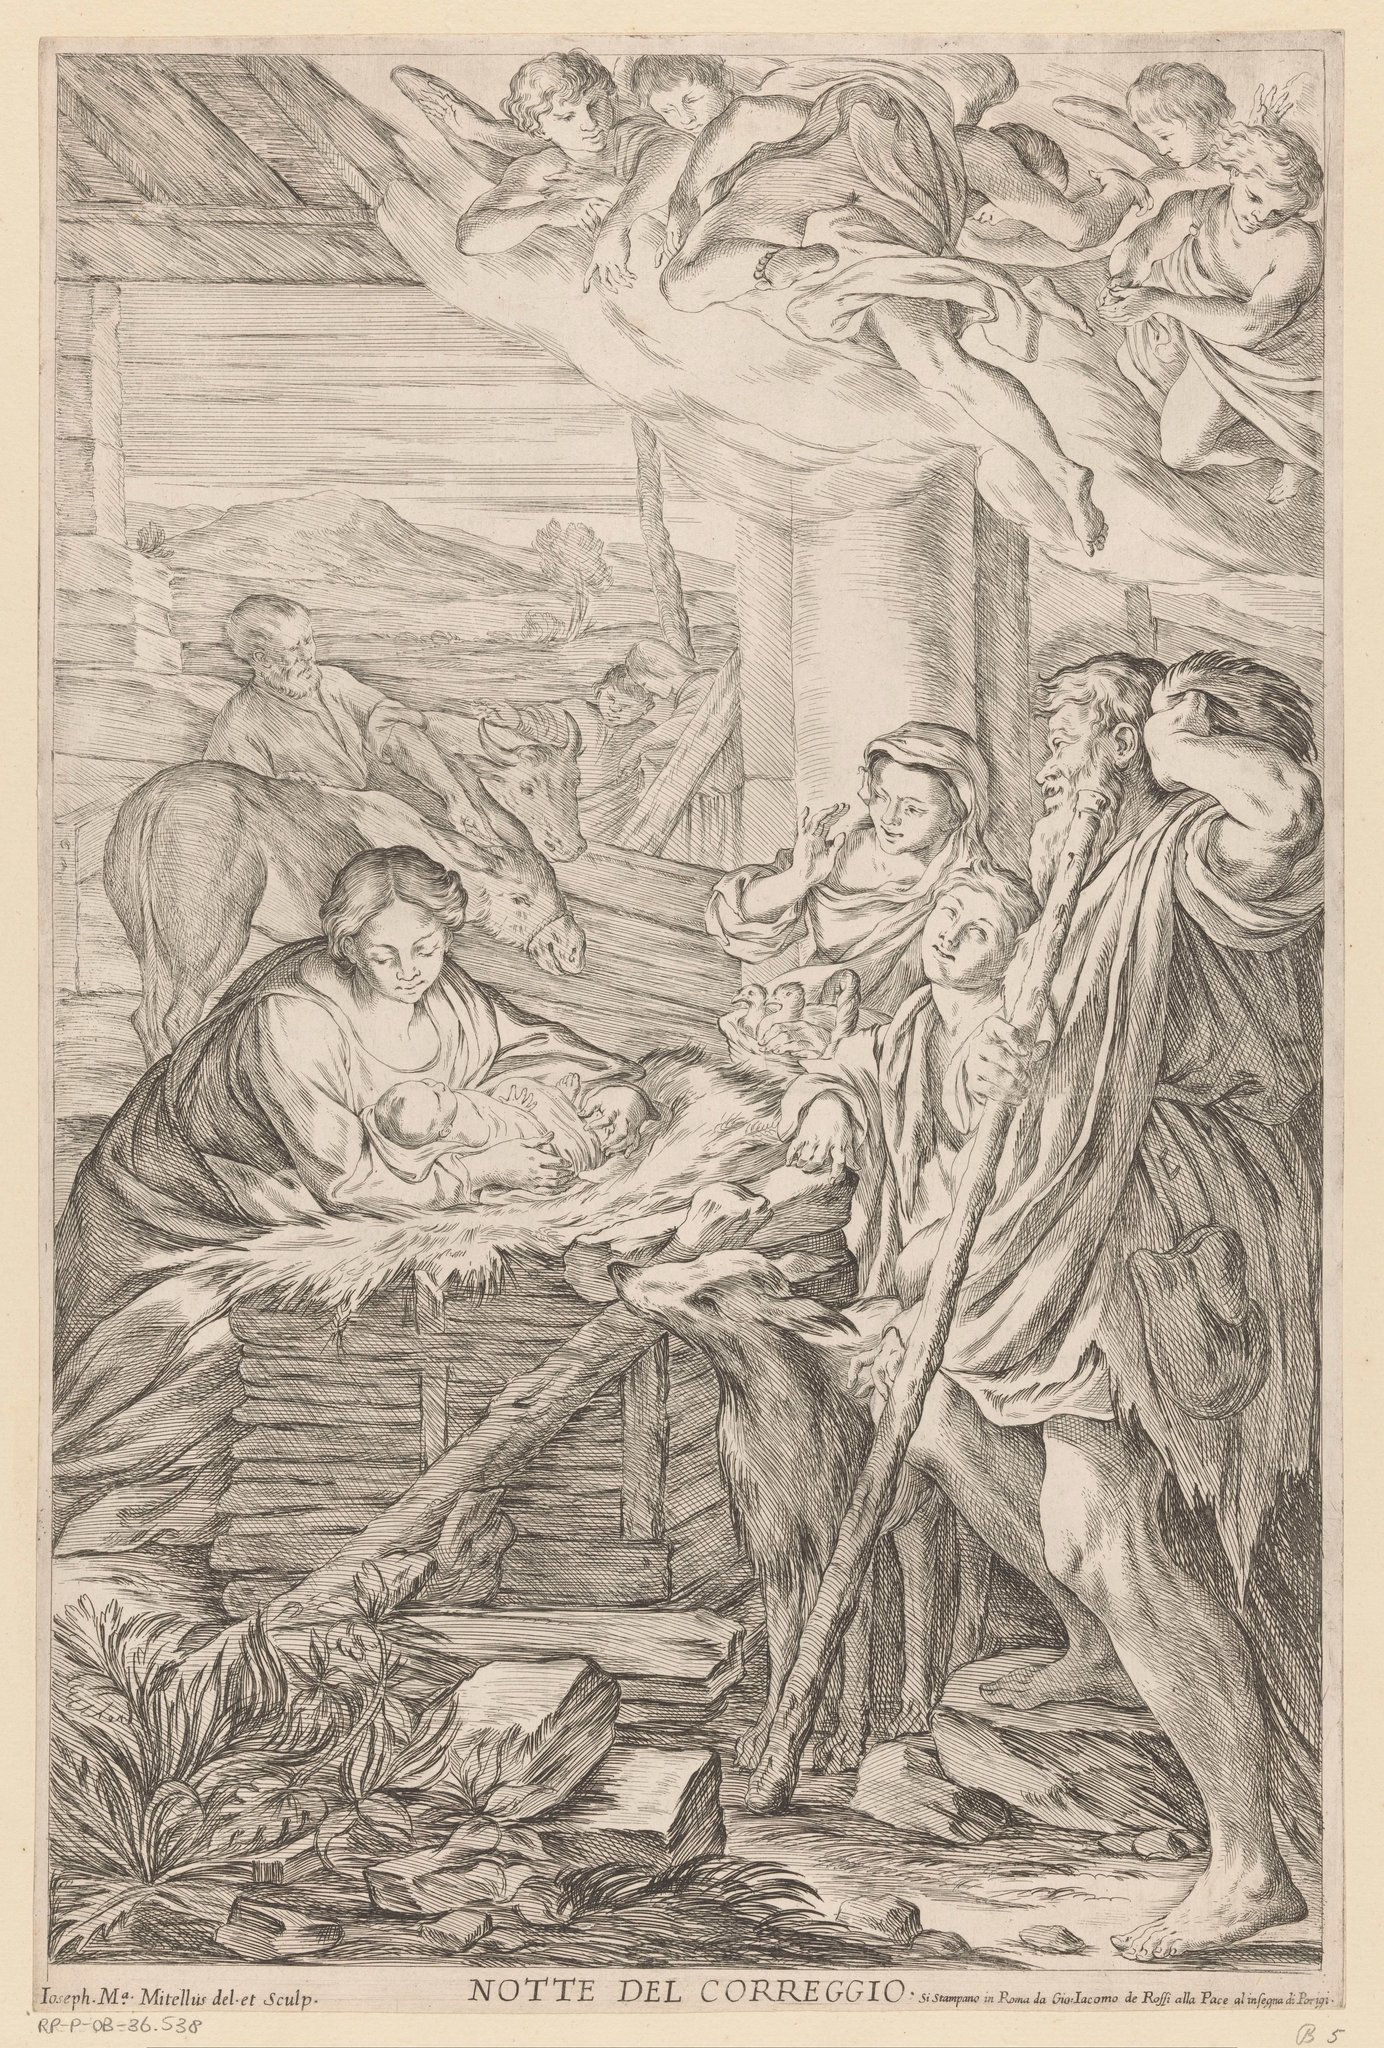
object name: print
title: Aanbidding door de herders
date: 1644-1718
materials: paper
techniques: etching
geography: italy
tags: adoration of the christ-child by the shepherds; mary and joseph present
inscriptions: collector's mark: Lugt 240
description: Gezicht in een stal met Maria knielend naast een kribbe met het Christuskind. Ze toont het Kind aan een groep herders rechts. Op de achtergrond Jozef met de os en de ezel. Rechtsboven zweven engelen. Titel in ondermarge.